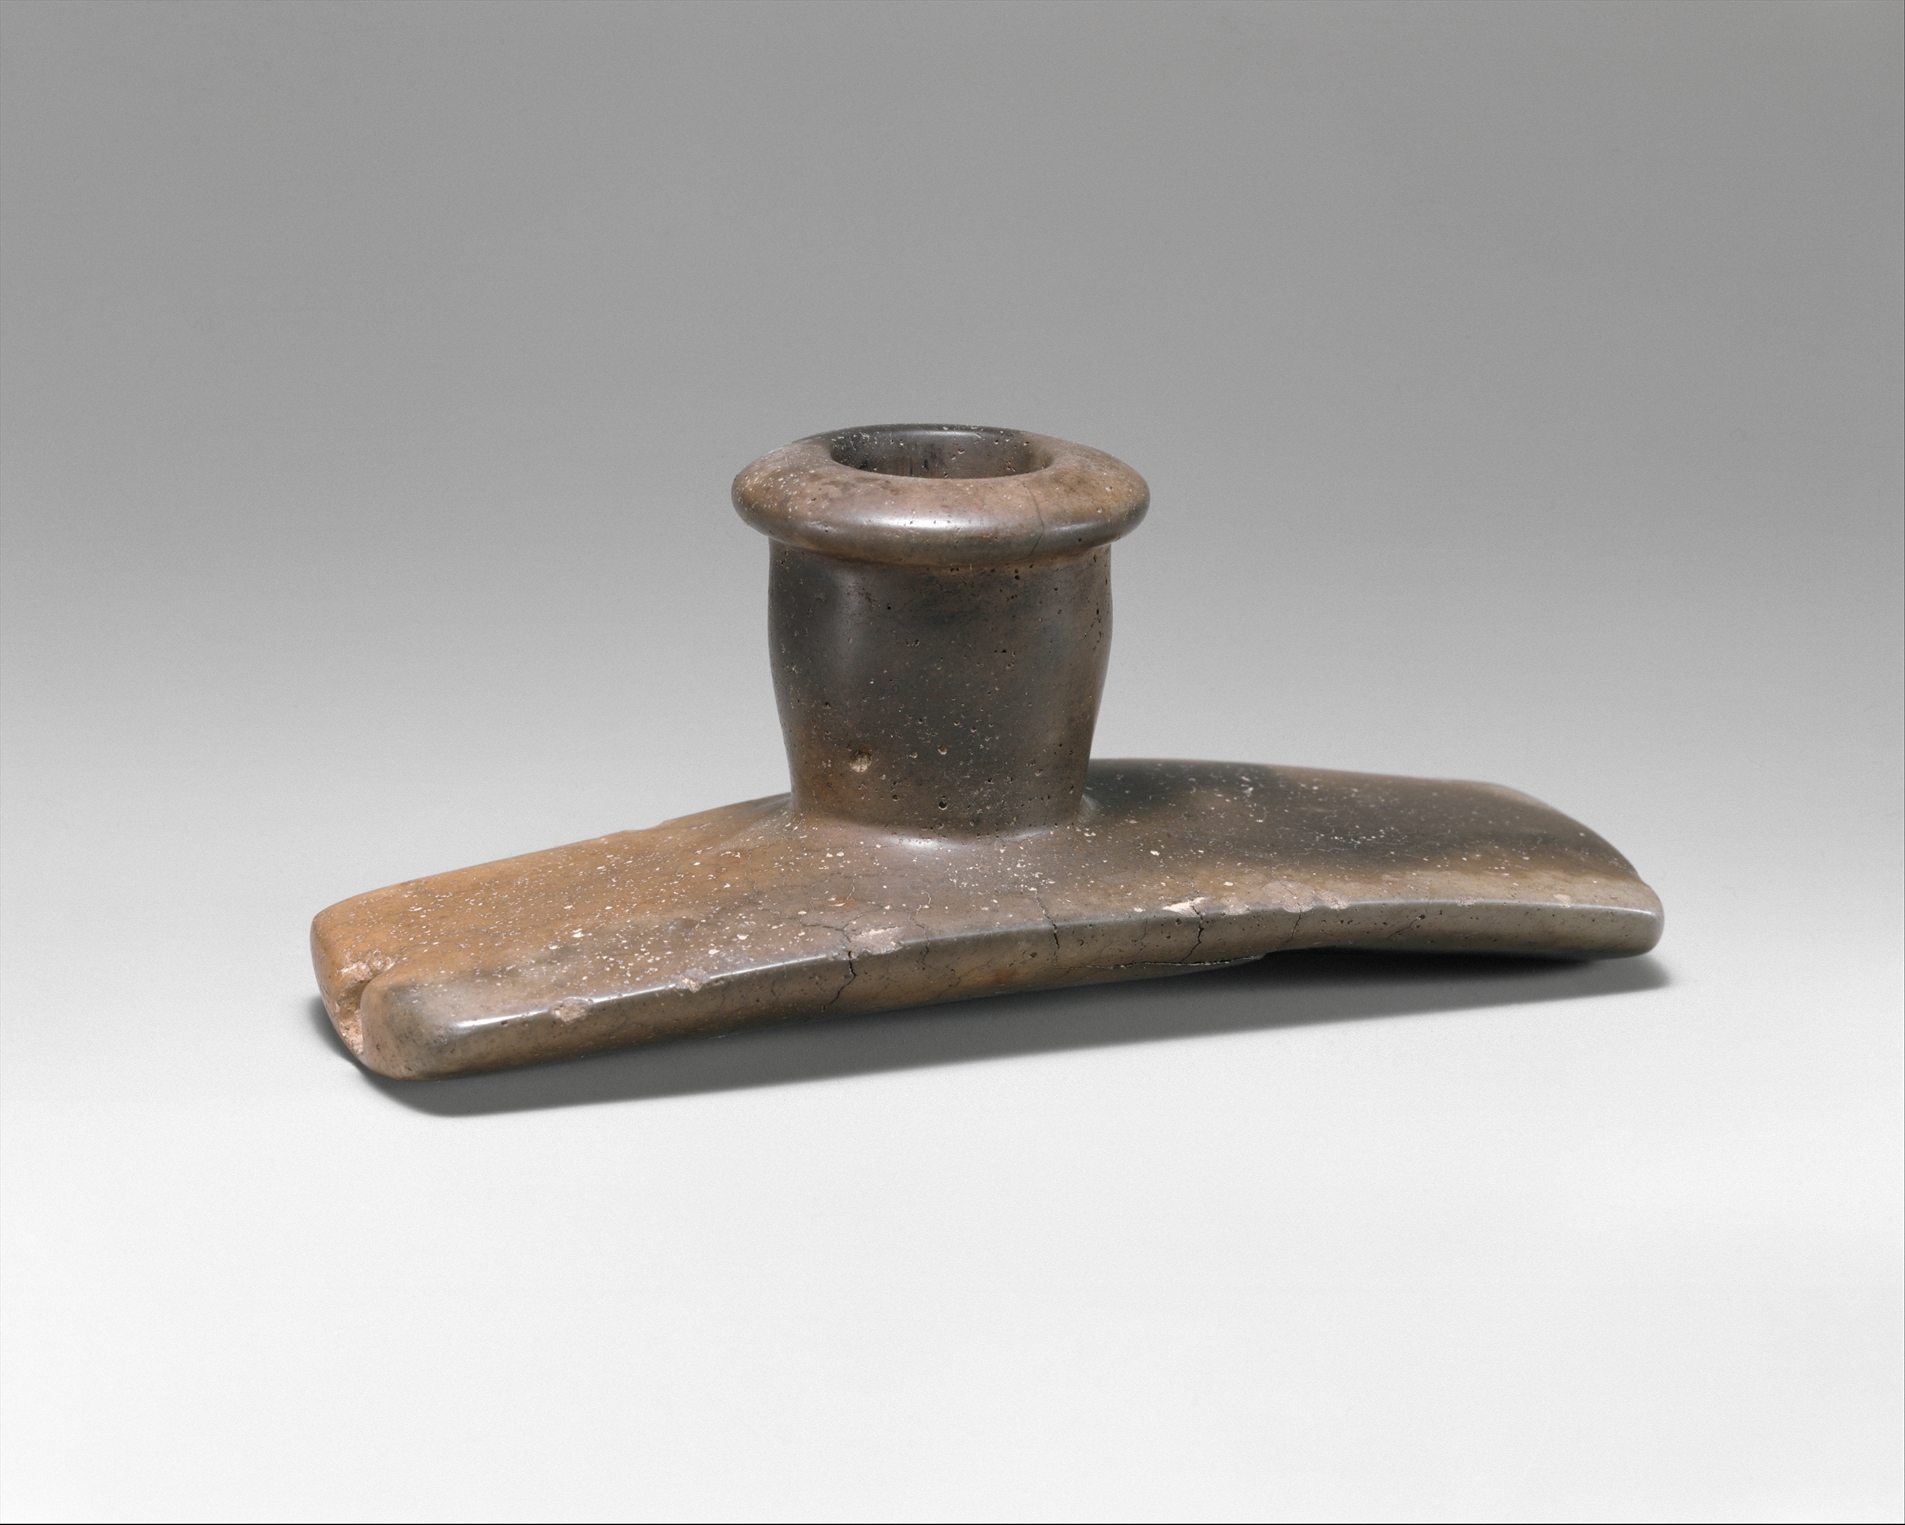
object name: pipe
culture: hopewellian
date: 100 BCE-300 CE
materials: ceramic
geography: united states